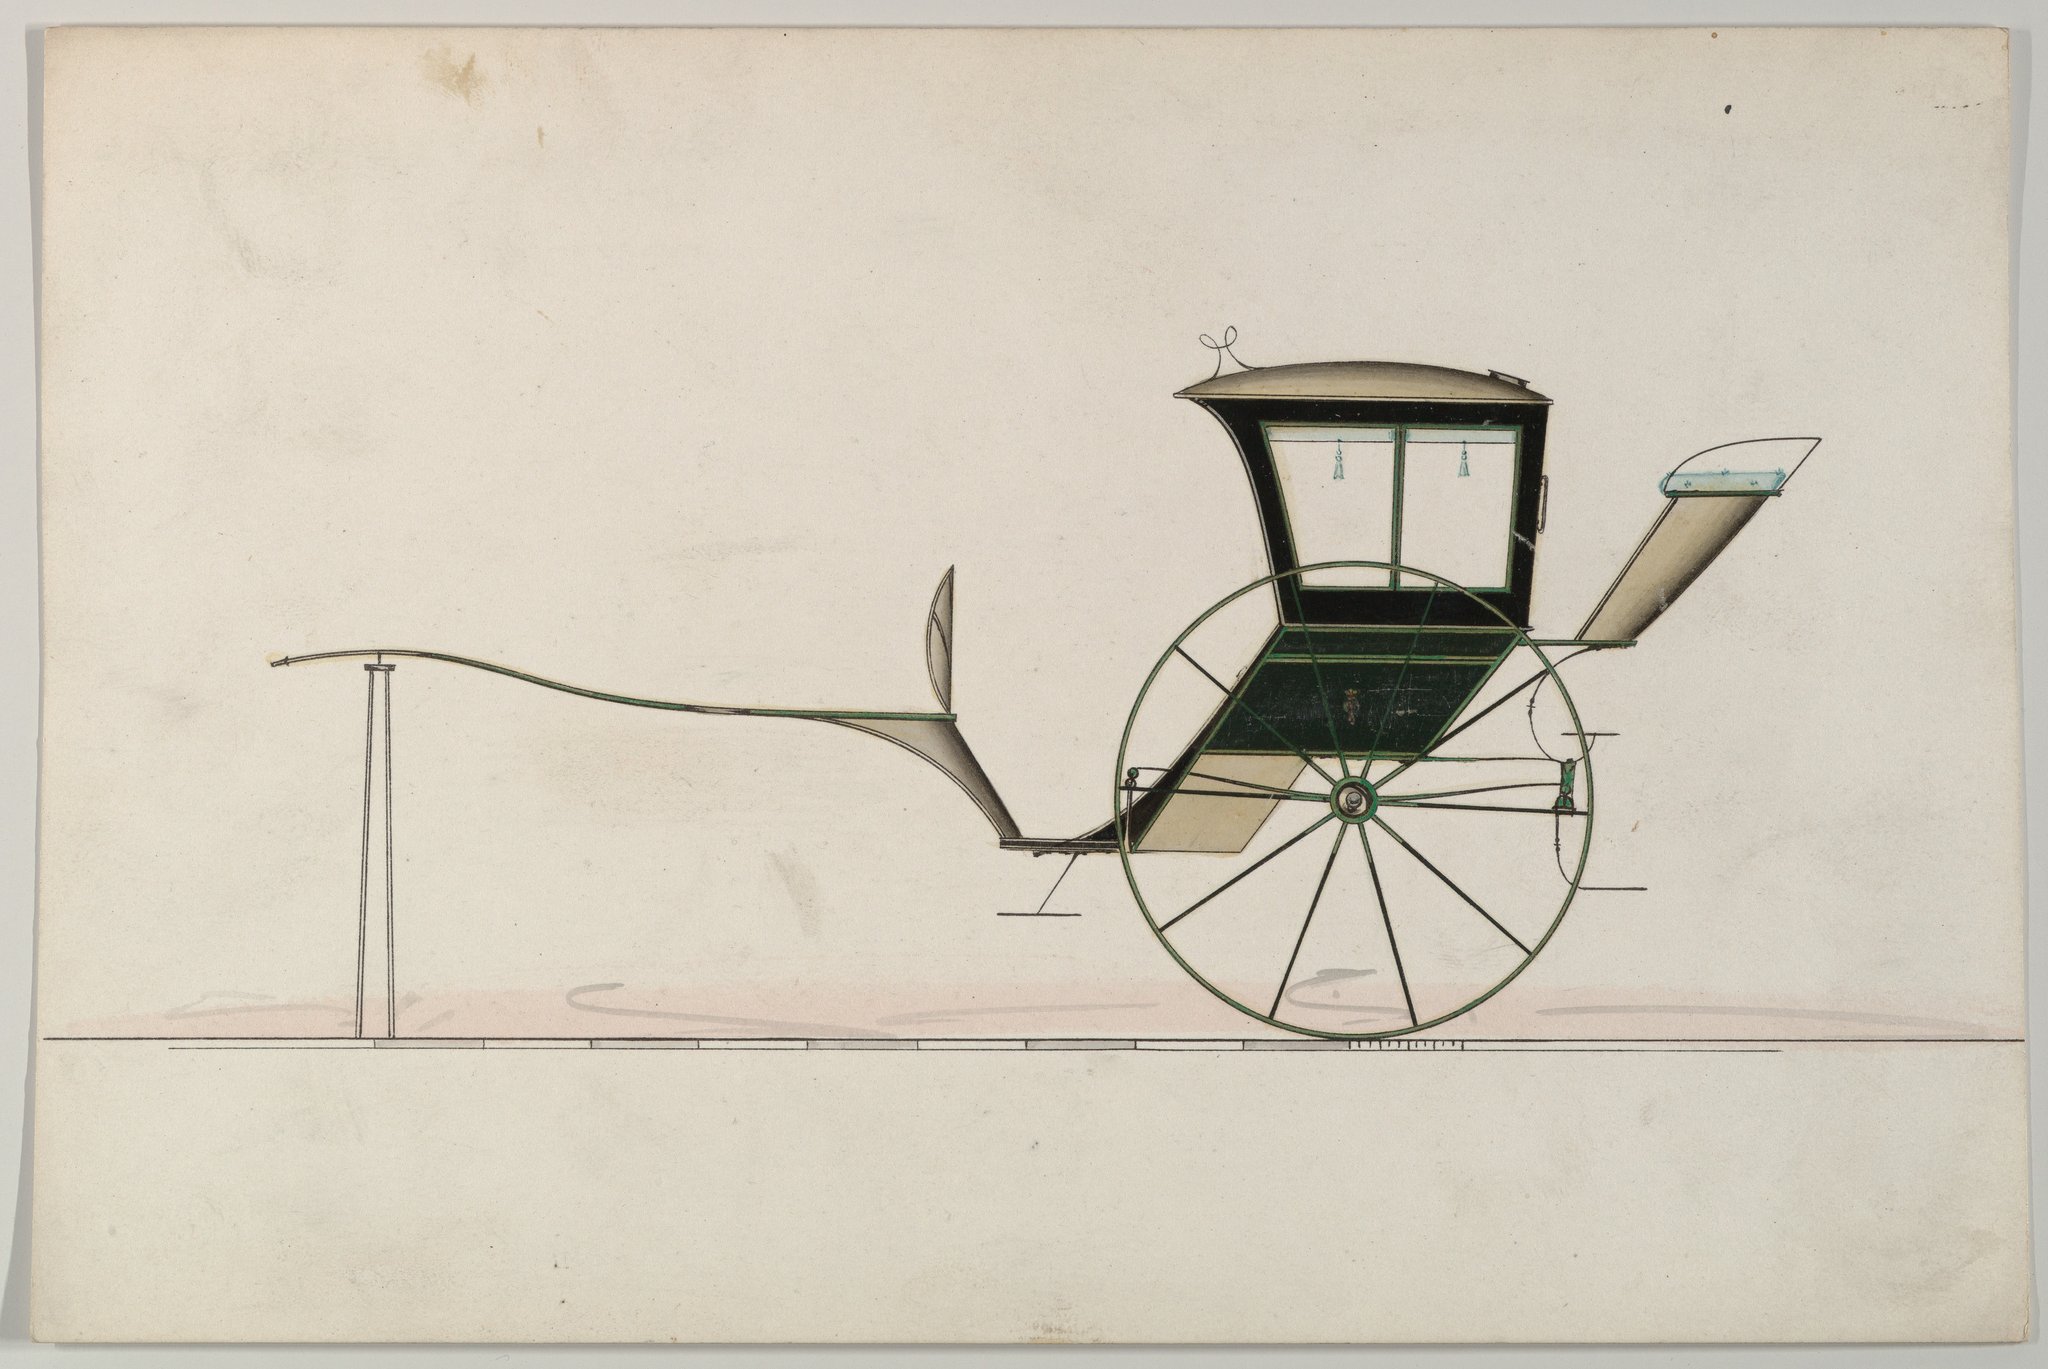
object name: drawing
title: Hansom Cab (unnumbered)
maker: brewster & co.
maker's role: manufacturer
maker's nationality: american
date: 1880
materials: gouache, gum arabic, ink, watercolor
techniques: pen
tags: carriages